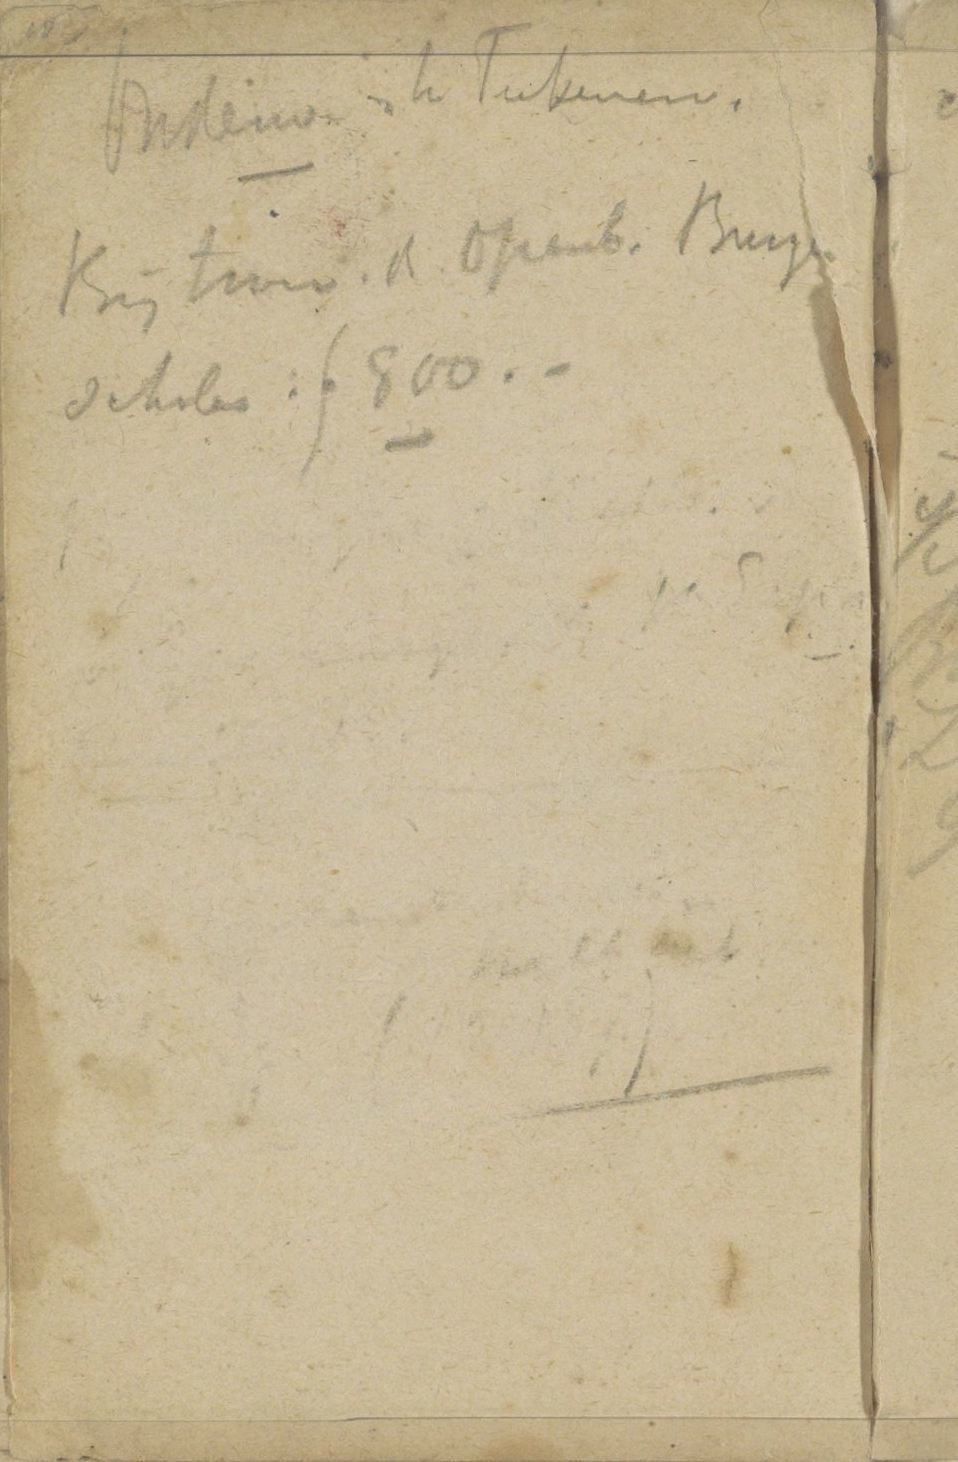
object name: sketchbook leaf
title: Annotaties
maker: george hendrik breitner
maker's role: draughtsman, painter, print maker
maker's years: 1857-1923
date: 1881-1883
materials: paper, pencil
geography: south holland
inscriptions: annotation: ‘Onderw. i h Teekenen./ Krijt[...] Openb. Burger-/ scholen: f 800,-’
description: Annotaties. Pagina 68 uit een schetsboek met 43 bladen.